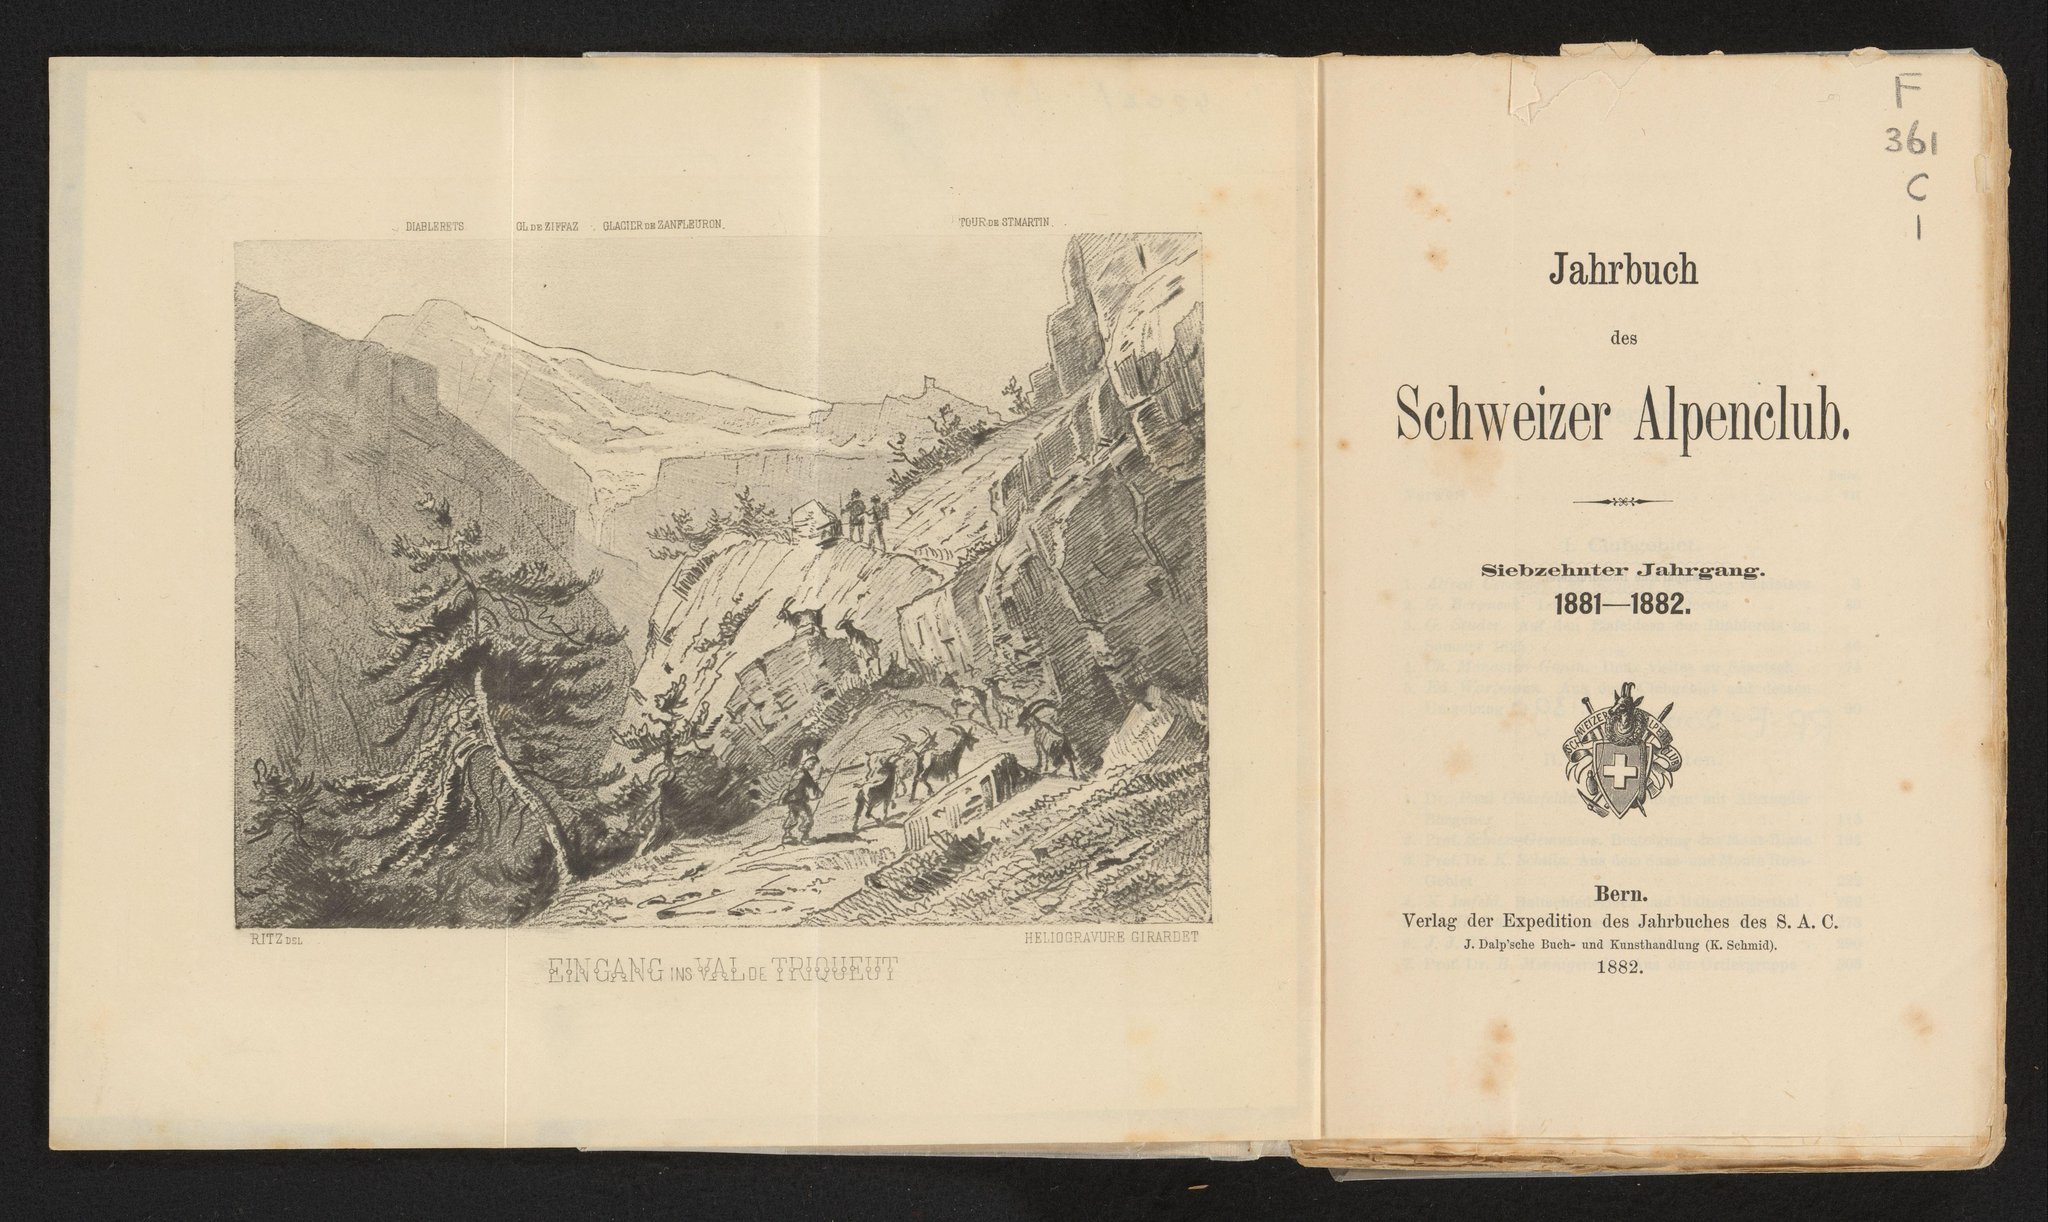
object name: photomechanical print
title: Reproductie van een tekening van een herder met geiten in de Alpen, Zwitserland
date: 1877-1882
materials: paper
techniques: photoaquatint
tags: herding, herdsman, herdswoman, shepherd, shepherdess, cowherd, etc., mountain-range, snow peaks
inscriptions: inscription: ‘DIABLERETS - GL de ZIFFAZ - GLACIER de ZANFLEURON - TOURS de STMARTIN’